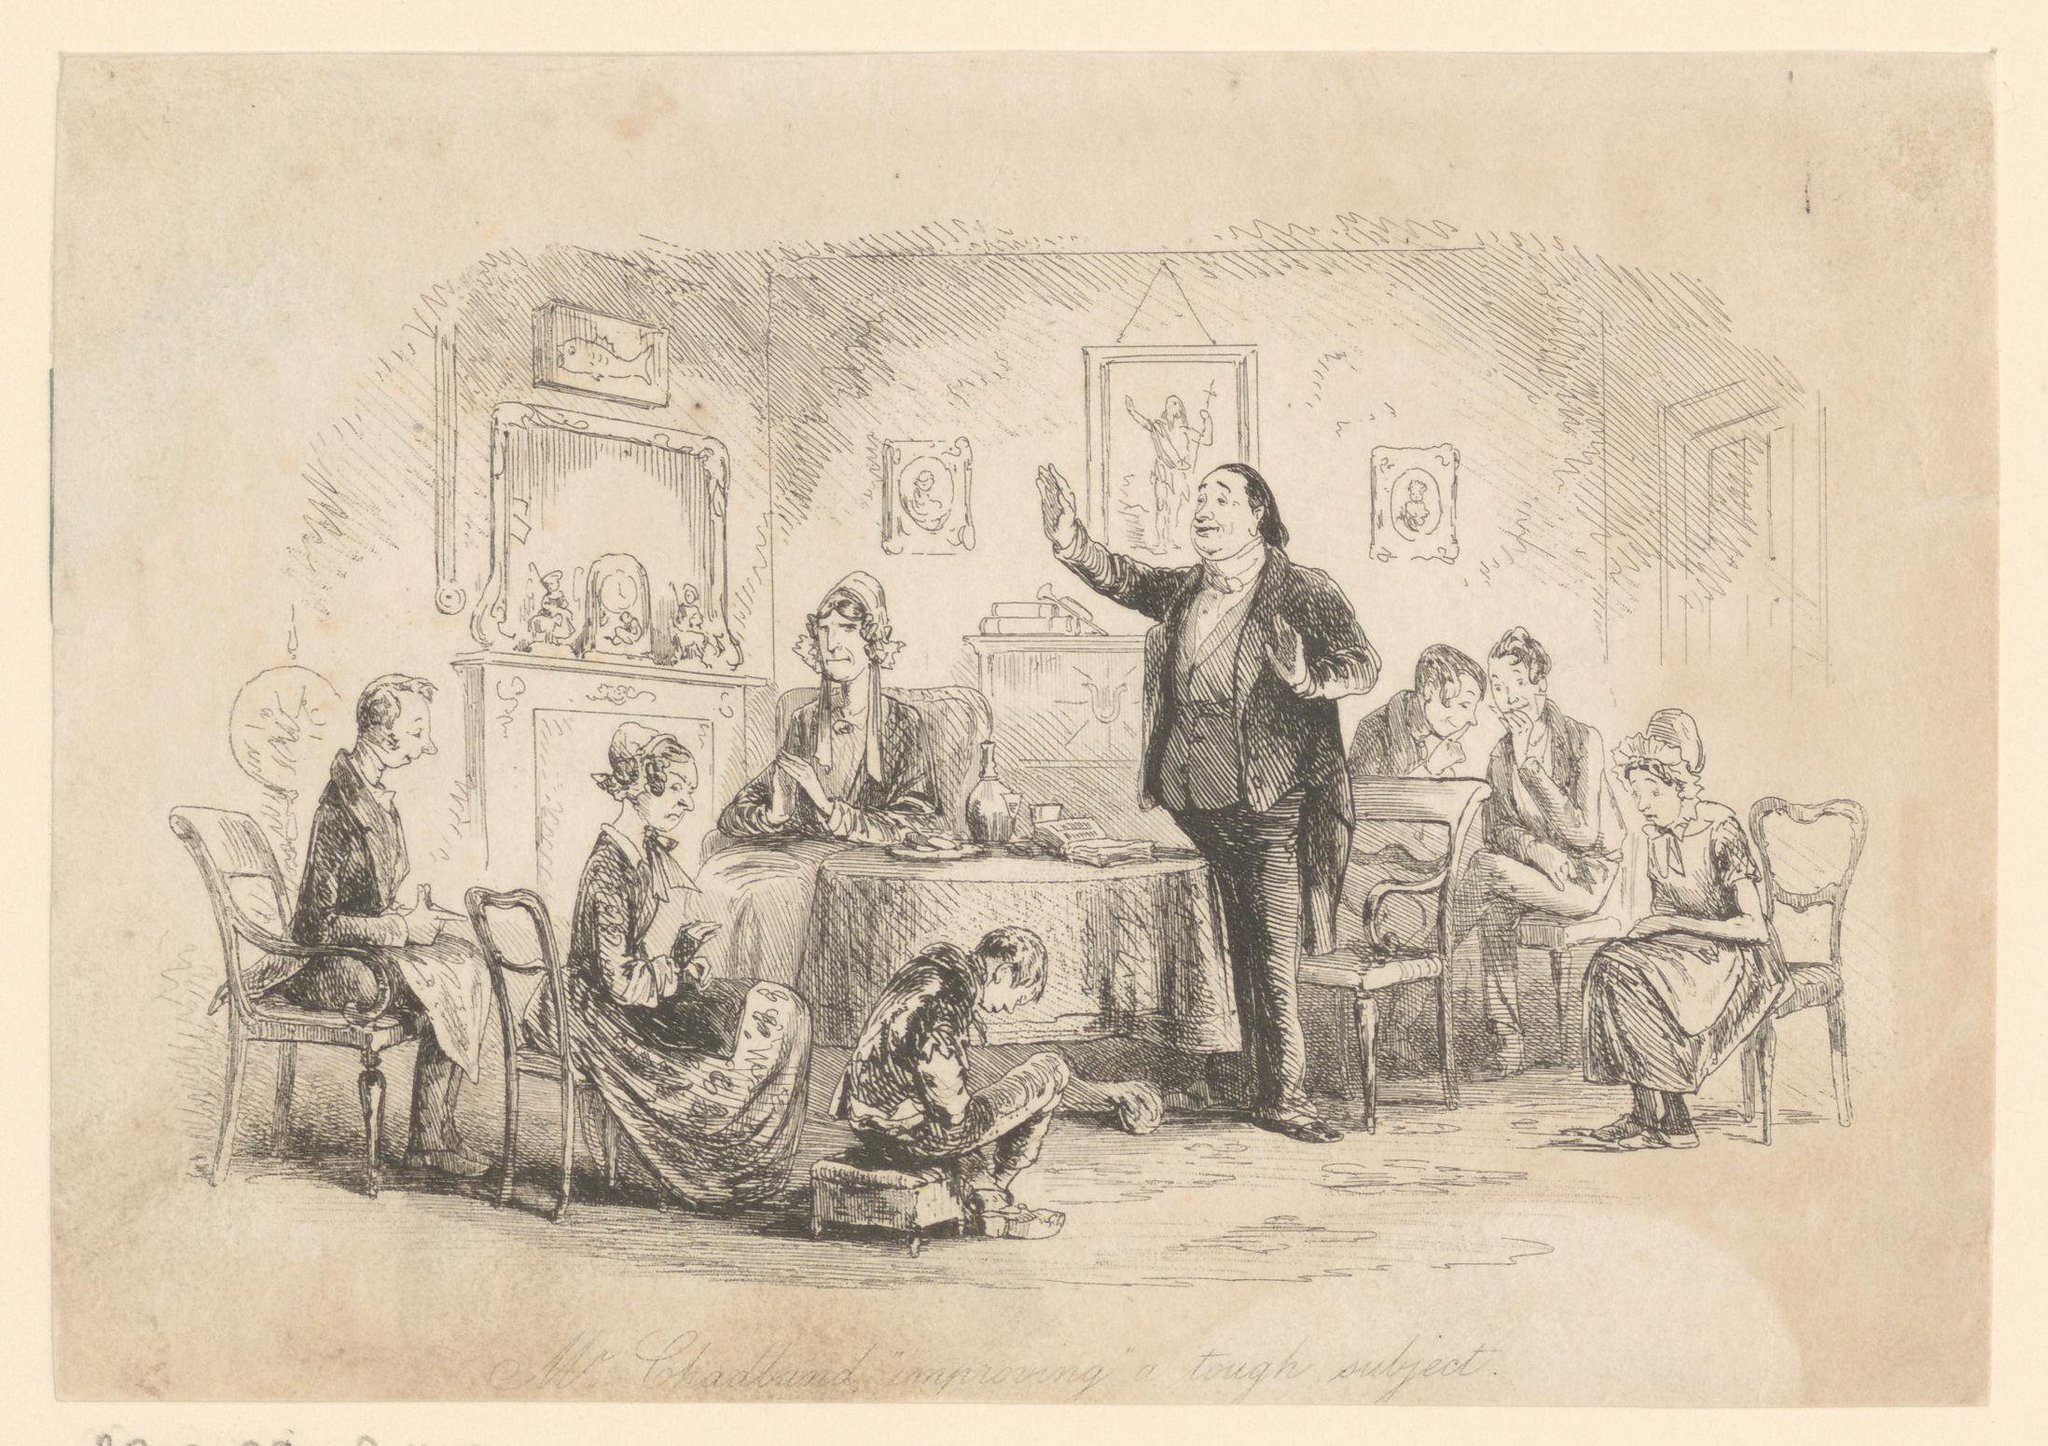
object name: book illustration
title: Mr. Chadband 'improving' a tough subject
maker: hablot knight browne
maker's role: print maker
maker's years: 1815-1882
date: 1853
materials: paper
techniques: etching, letterpress printing, roulette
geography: london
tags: preaching (in general), living-room, parlour, sitting-room, person addressing a group, orator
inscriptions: collector's mark: Lugt 2228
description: Prent uit: Dickens, Charles. Bleak House. Londen: Bradbury & Evans, 1853, p. 254.